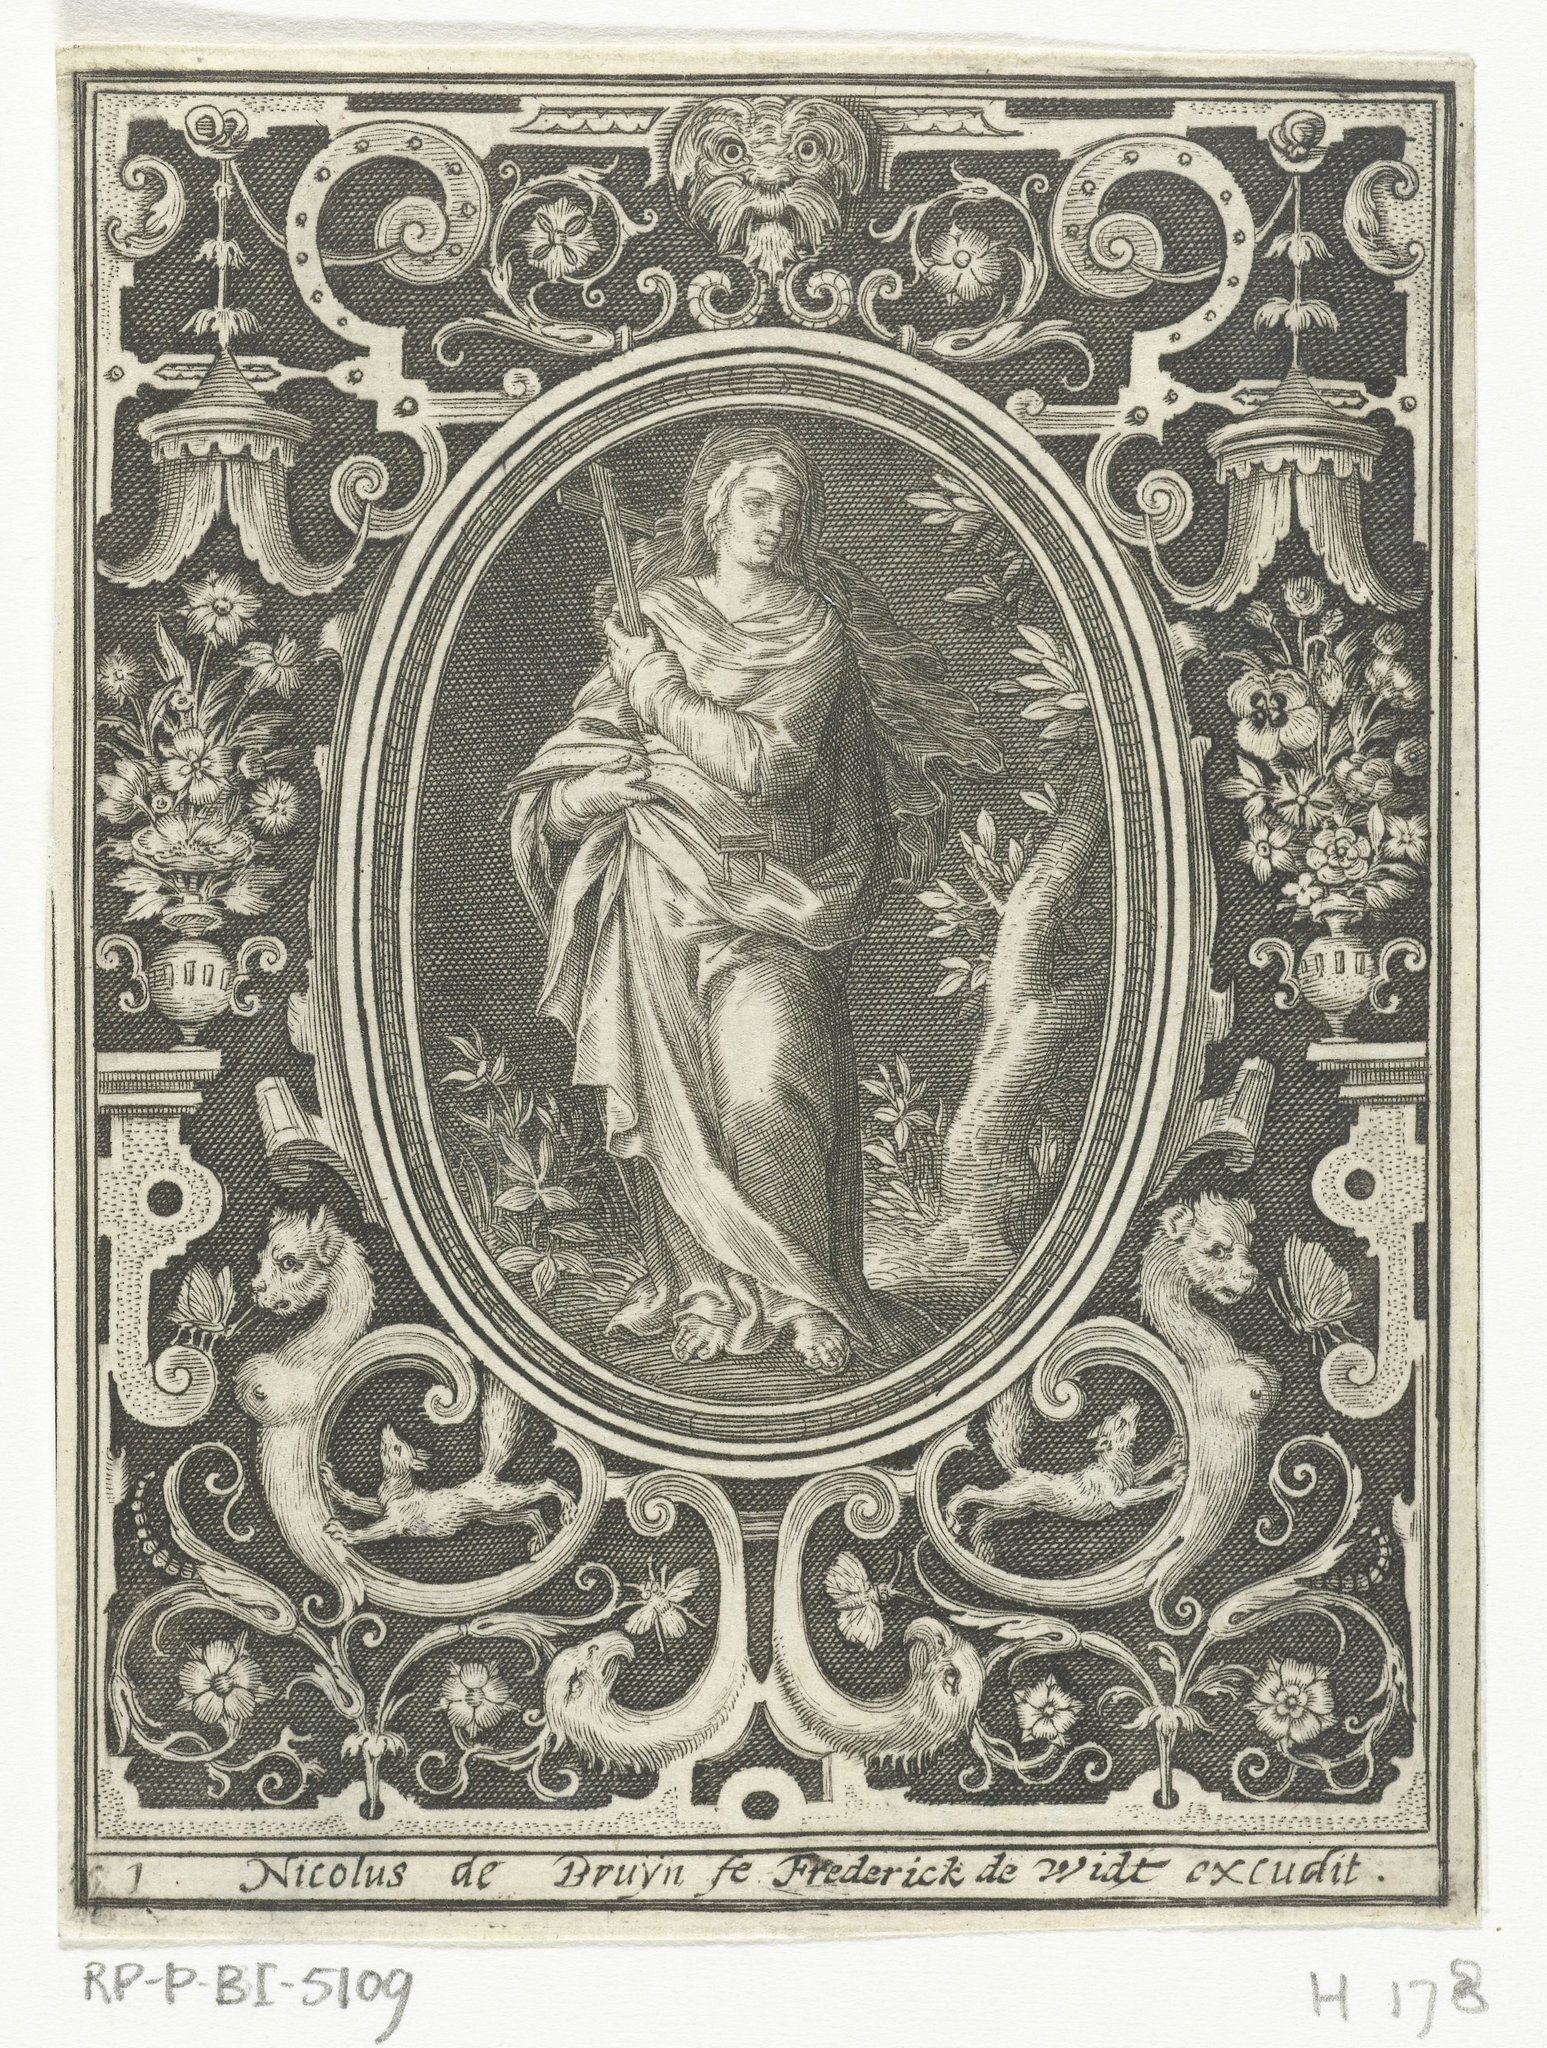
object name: print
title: Vier deugden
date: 1581-1656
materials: paper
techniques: engraving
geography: netherlands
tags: faith, 'fides'; 'fede', 'fede catholica', 'fede christiana', 'fede christiana catholica' (ripa) ~ one of the three theological virtues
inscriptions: collector's mark: Lugt 2228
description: Prent uit serie van vier prenten met deugden. De vier prenten in de collectie van het RMA vertegenwoordigen mogelijk vier verschillende uitgaven en staten van de reeks want het signatuur van de vervaardiger en het adres van de uitgever zijn steeds afwijkend genoteerd.